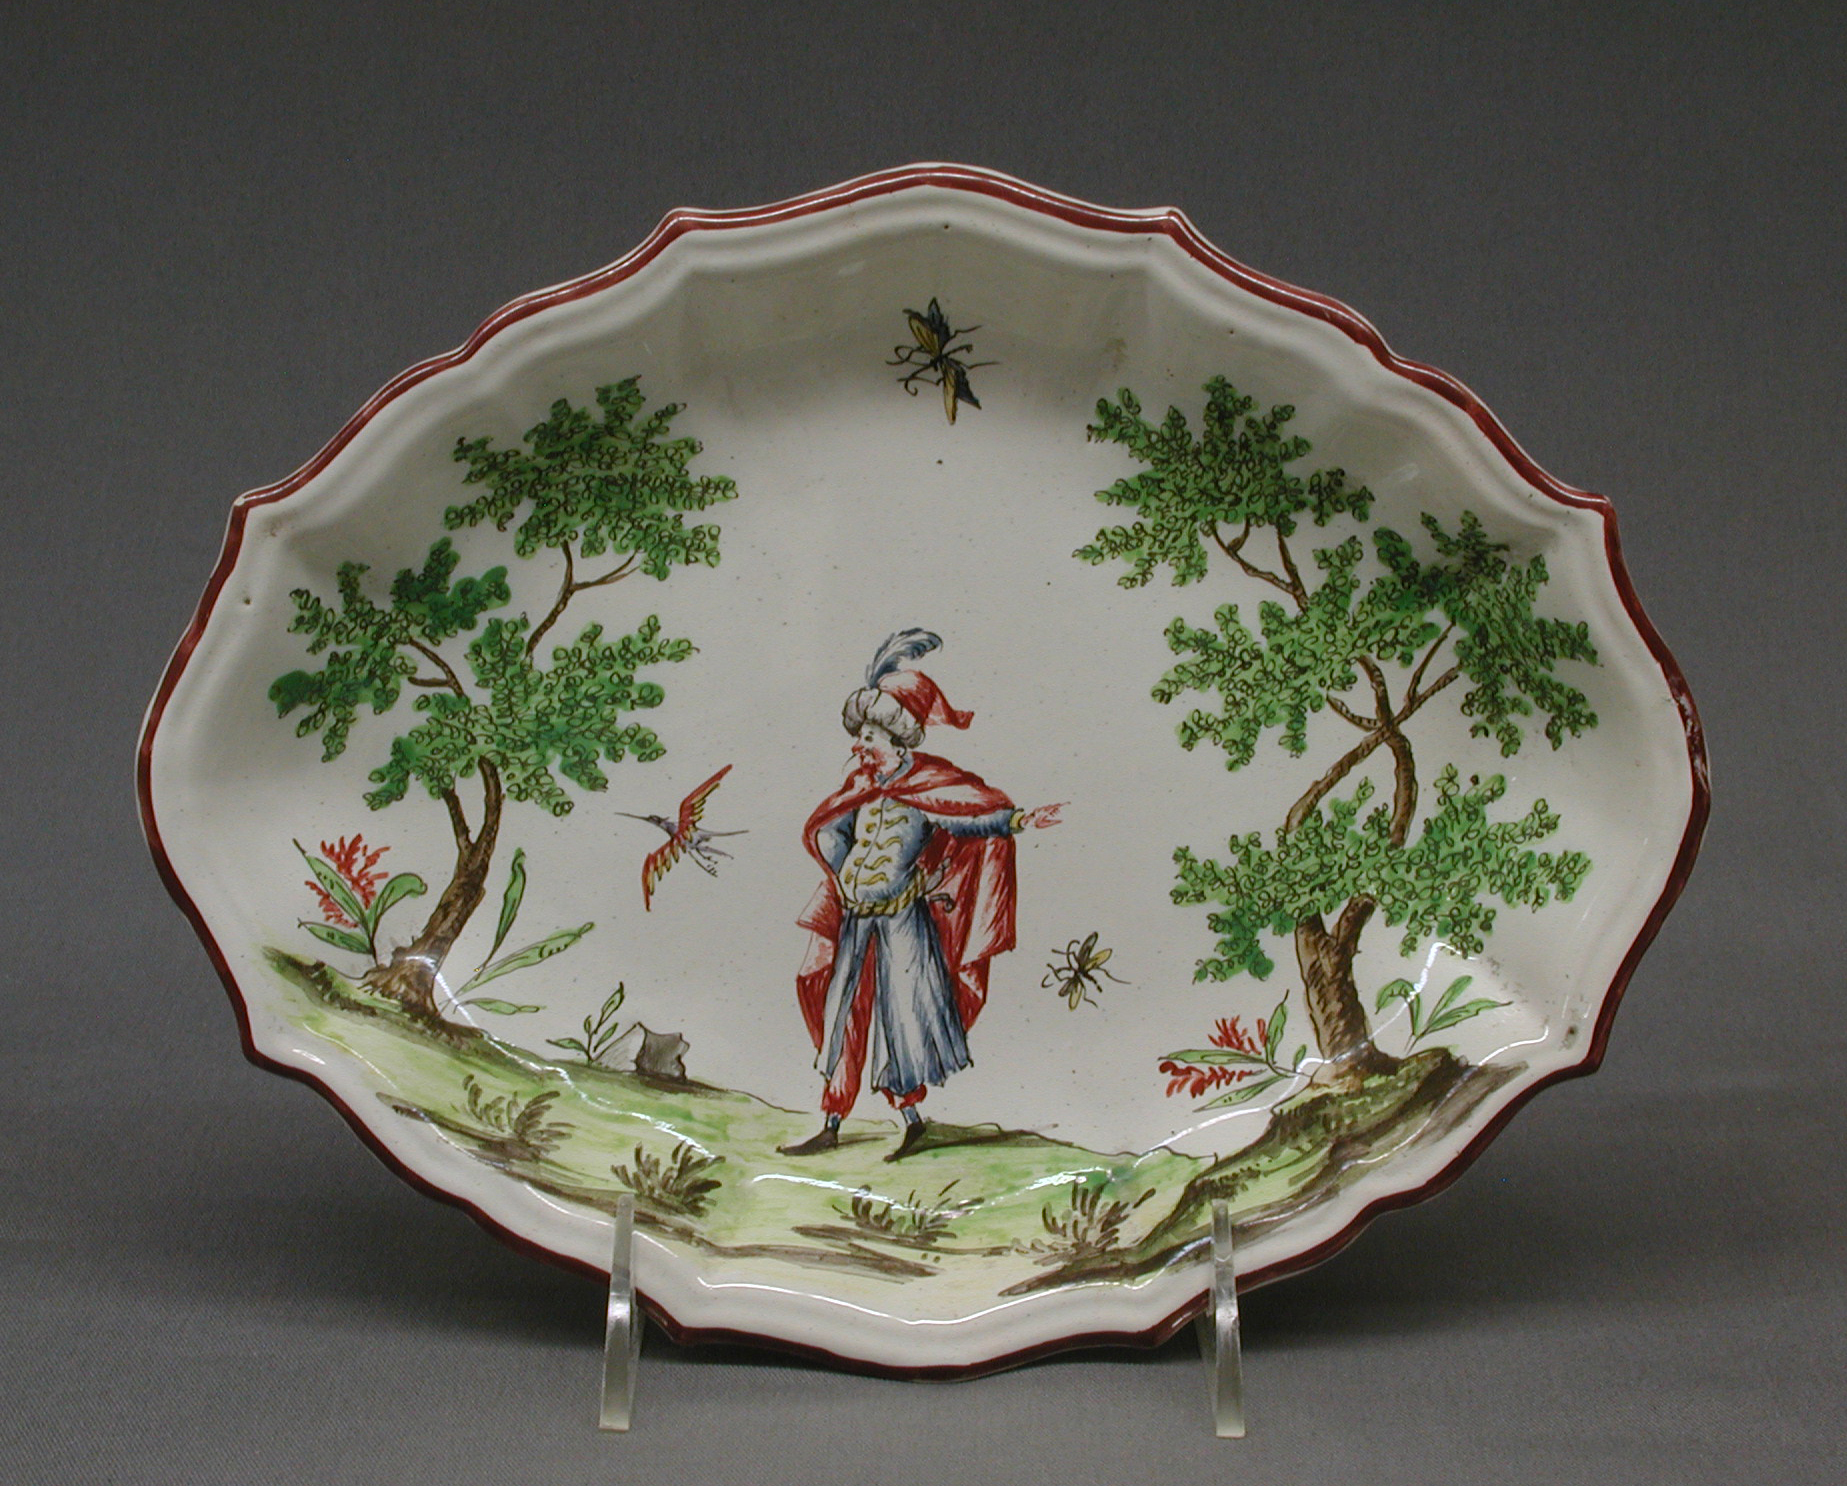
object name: dish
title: Dish (one of a pair)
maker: felice clerici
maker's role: maker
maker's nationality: italian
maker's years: 1745-1788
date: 1750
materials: earthenware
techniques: enamel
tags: birds,men,insects,trees